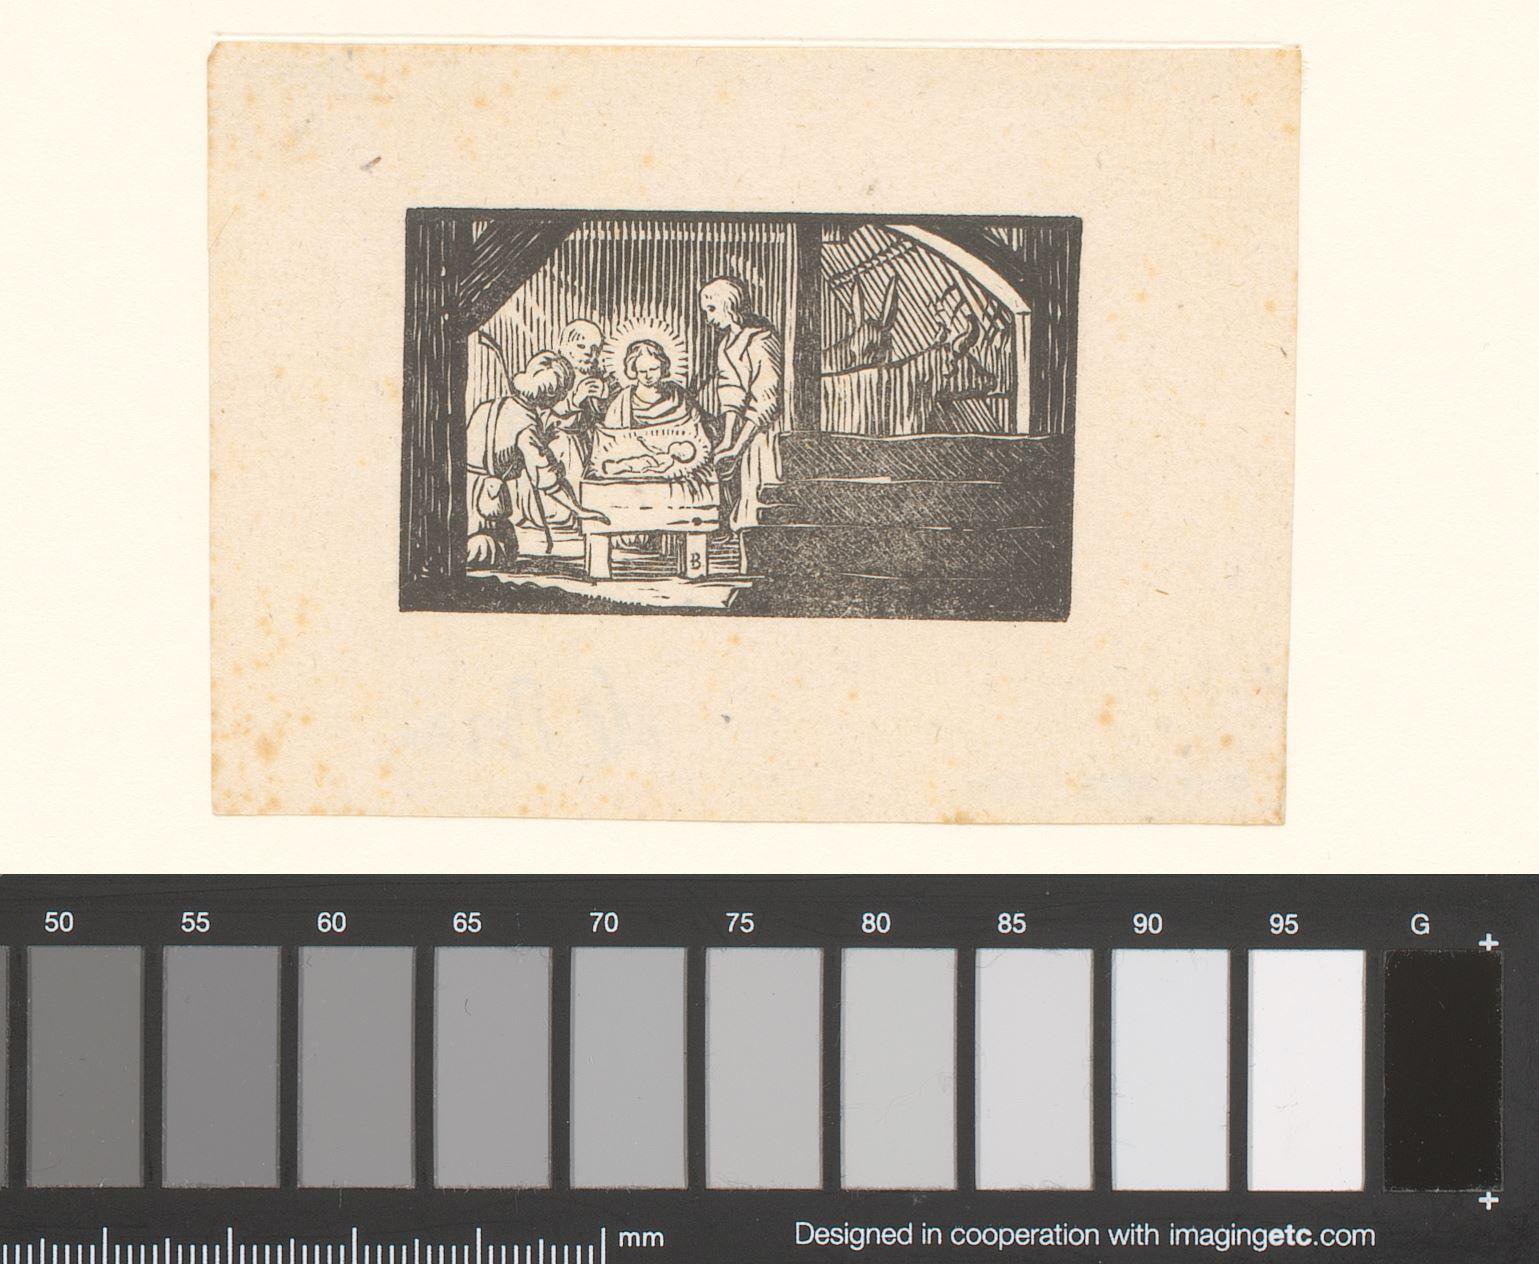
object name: print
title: Voorstellingen uit het Nieuwe Testament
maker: dirck de bray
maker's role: draughtsman, painter, print maker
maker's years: 1625-1694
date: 1635-1694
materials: paper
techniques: woodcut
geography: netherlands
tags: mary, joseph and the new-born christ (nativity)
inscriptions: collector's mark: Lugt 2228, collector's mark: Lugt 698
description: Prent 2 uit een 18-delige serie met voorstellingen uit het Nieuwe Testament.